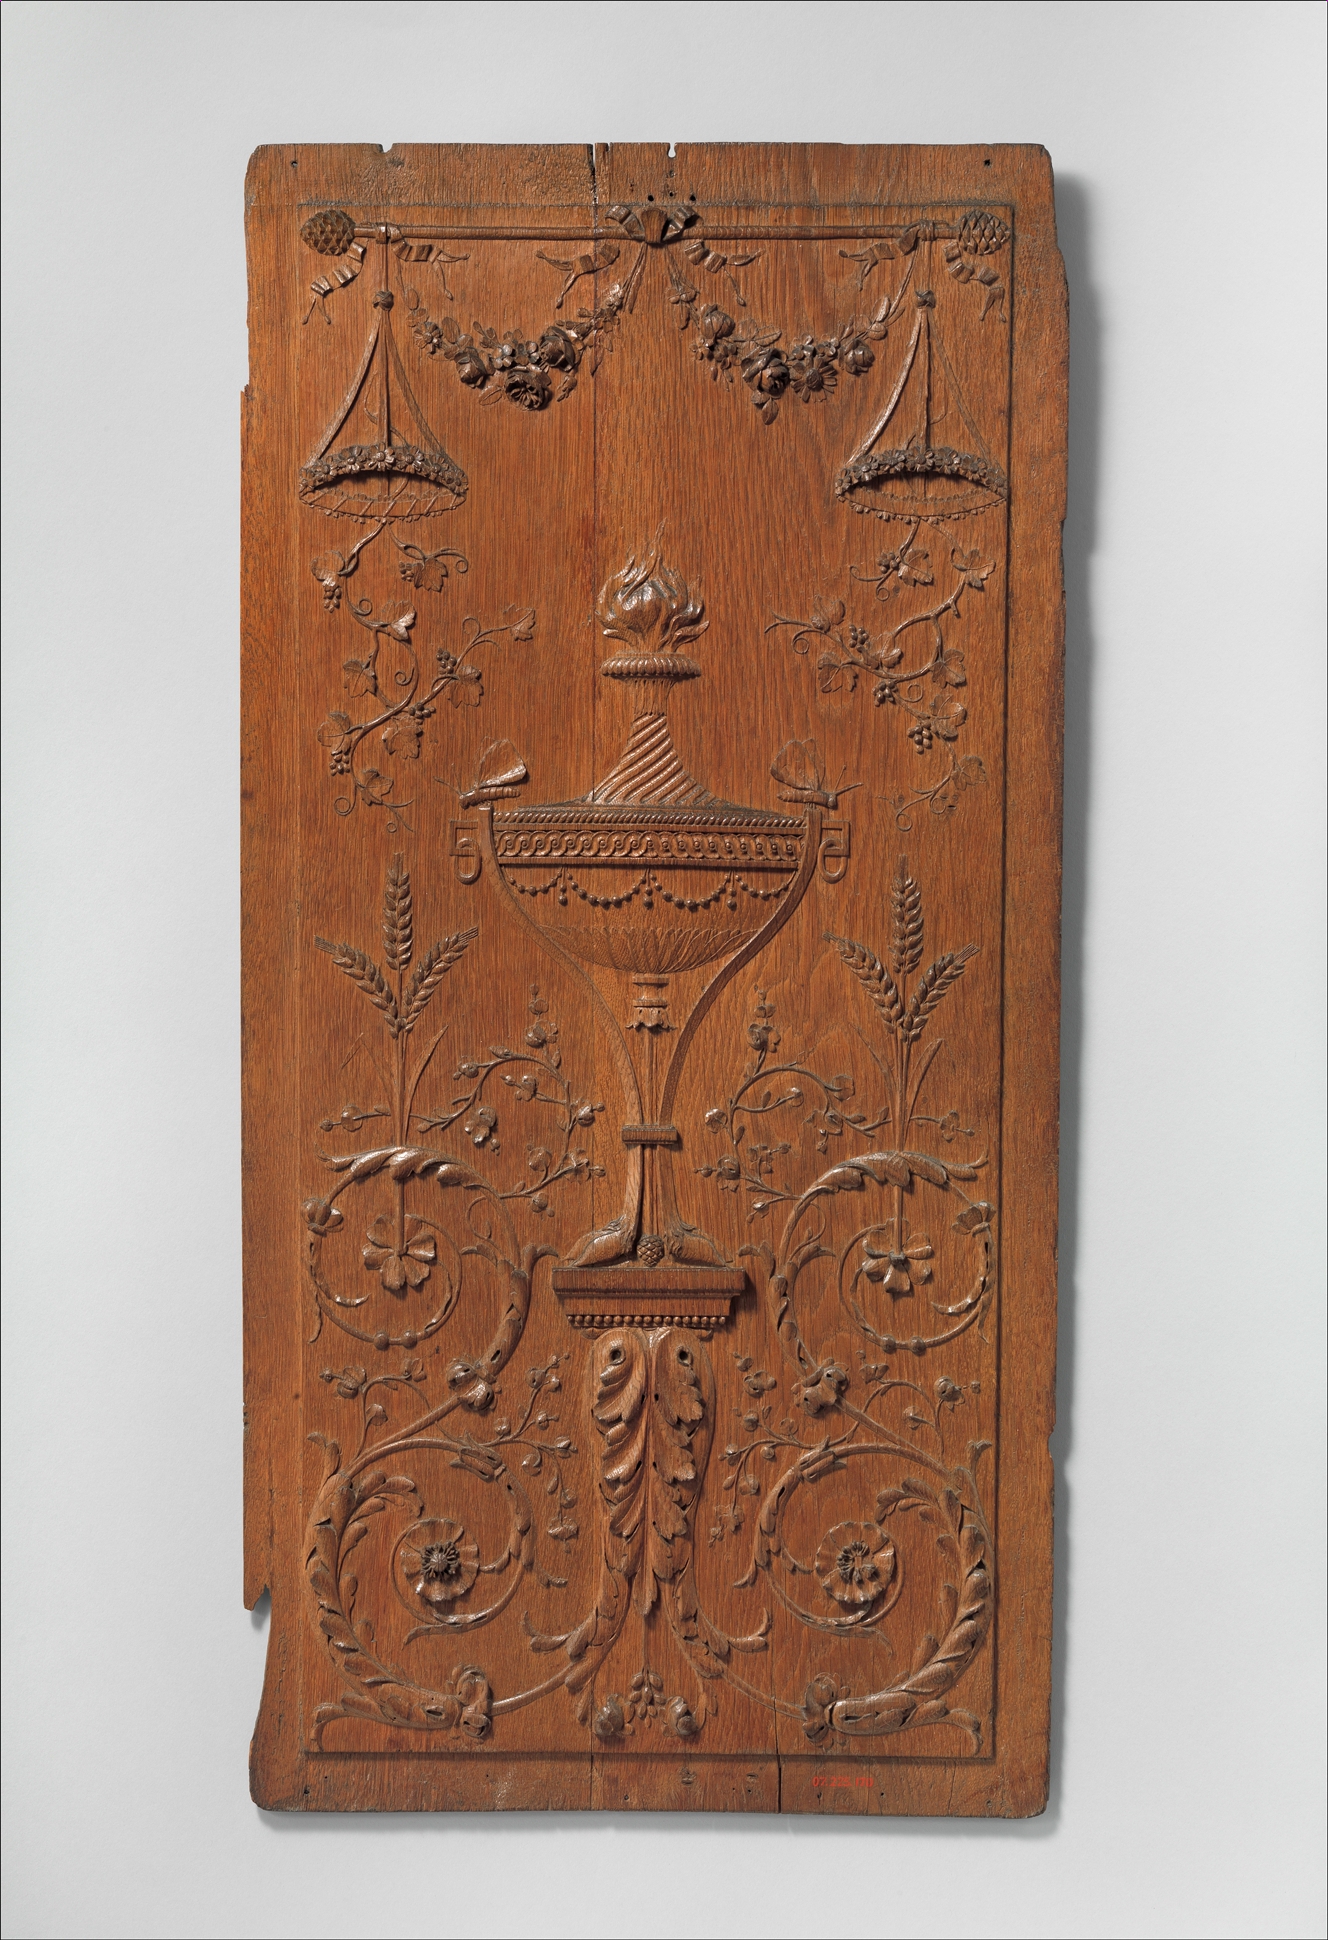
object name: panel model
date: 1780-1785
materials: wood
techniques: carving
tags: insects,flowers,leaves